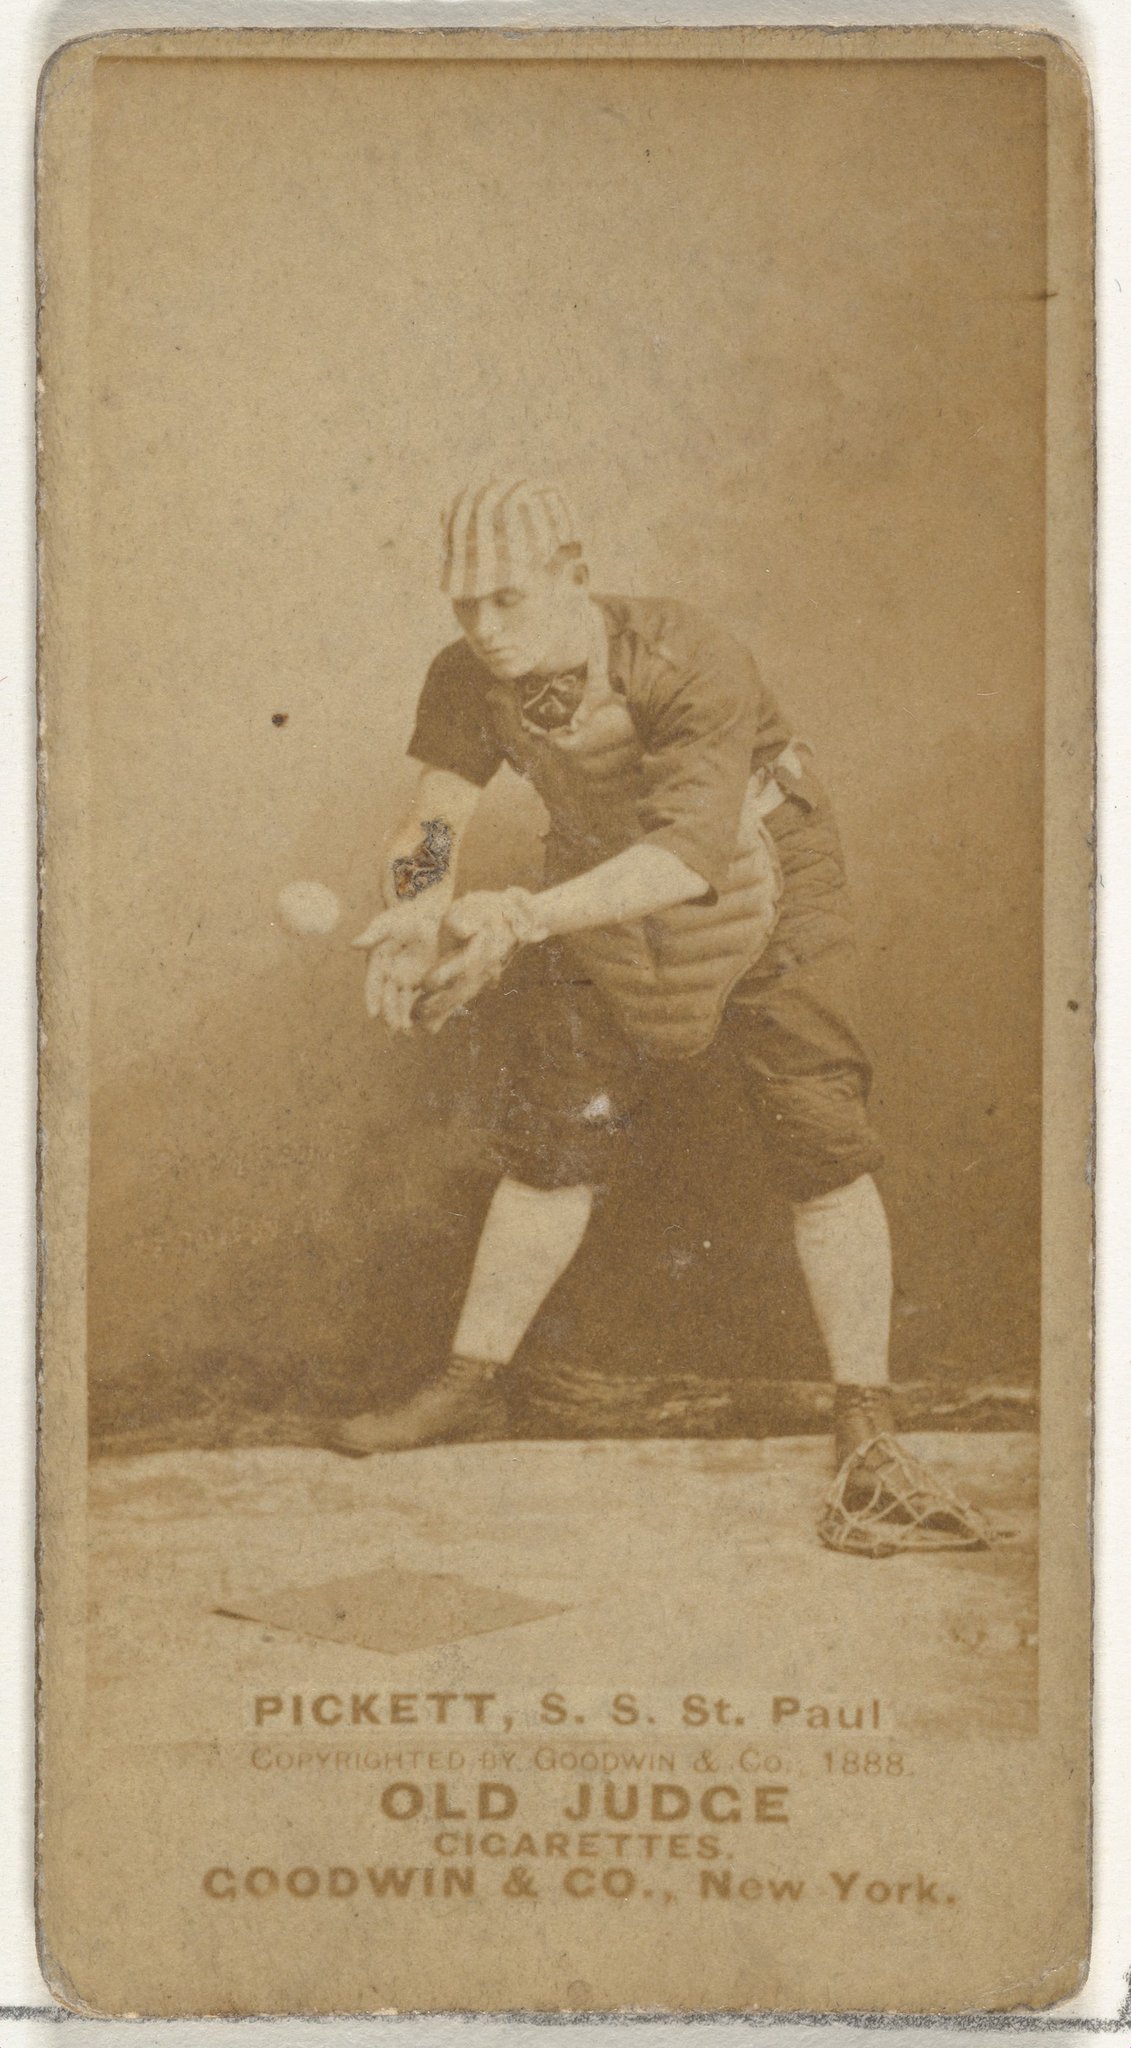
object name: baseball card, photograph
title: John Thomas Pickett, Shortstop, St. Paul Apostles, from the Old Judge series (N172) for Old Judge Cigarettes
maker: goodwin & company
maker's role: publisher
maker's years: 1850-1950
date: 1888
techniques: albumen silver print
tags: men,portraits,baseball,athletes